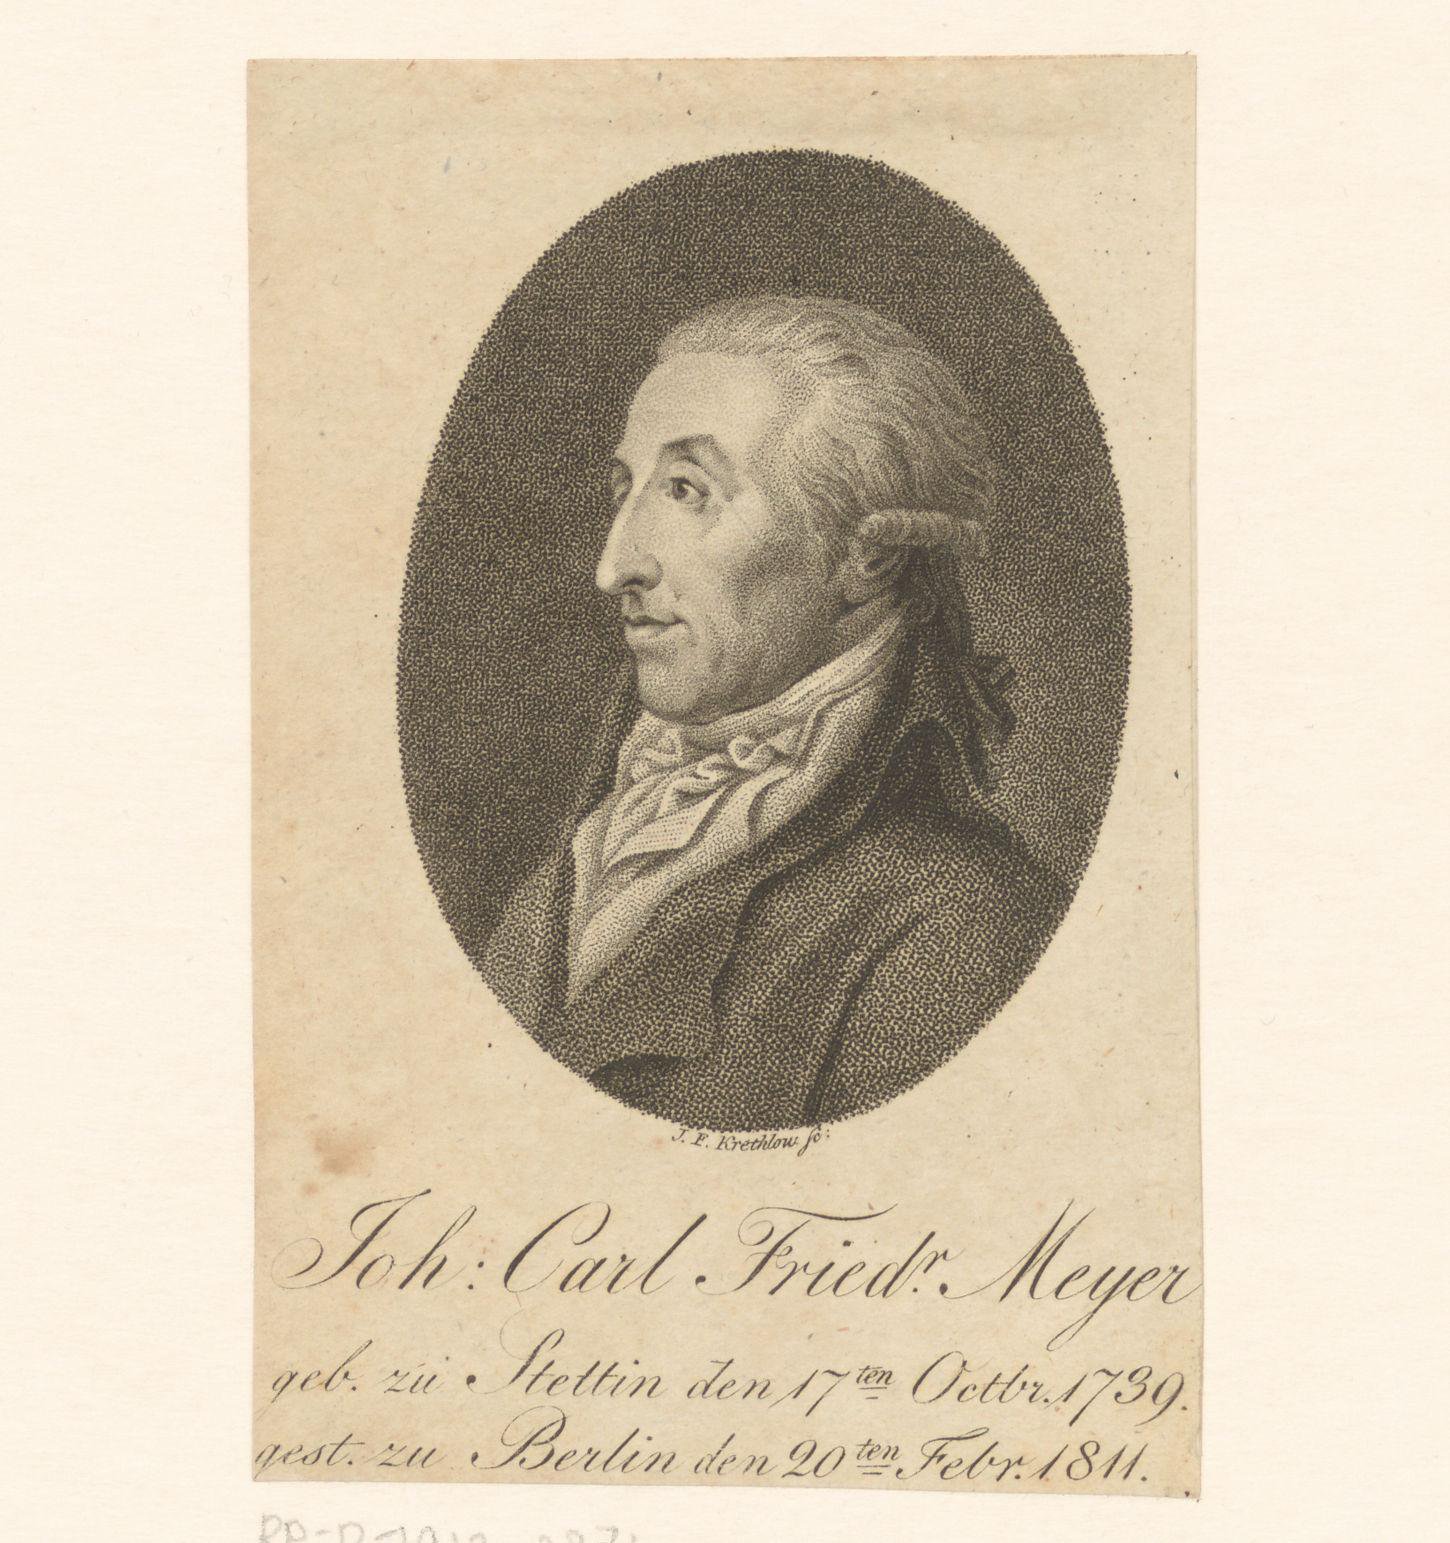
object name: print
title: Portret van Johann Carl Friedrich Meyer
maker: johann ferdinand krethlow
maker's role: artist, draughtsman, print maker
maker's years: 1767-1842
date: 1777-1842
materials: paper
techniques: stippling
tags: berlin, chemistry (+ portrait of scholar, scientist), pharmacist, druggist, apothecary; pharmacy, drugstore, dispensing chemist (+ portrait of scholar, scientist), historical persons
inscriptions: collector's mark: Lugt 2228